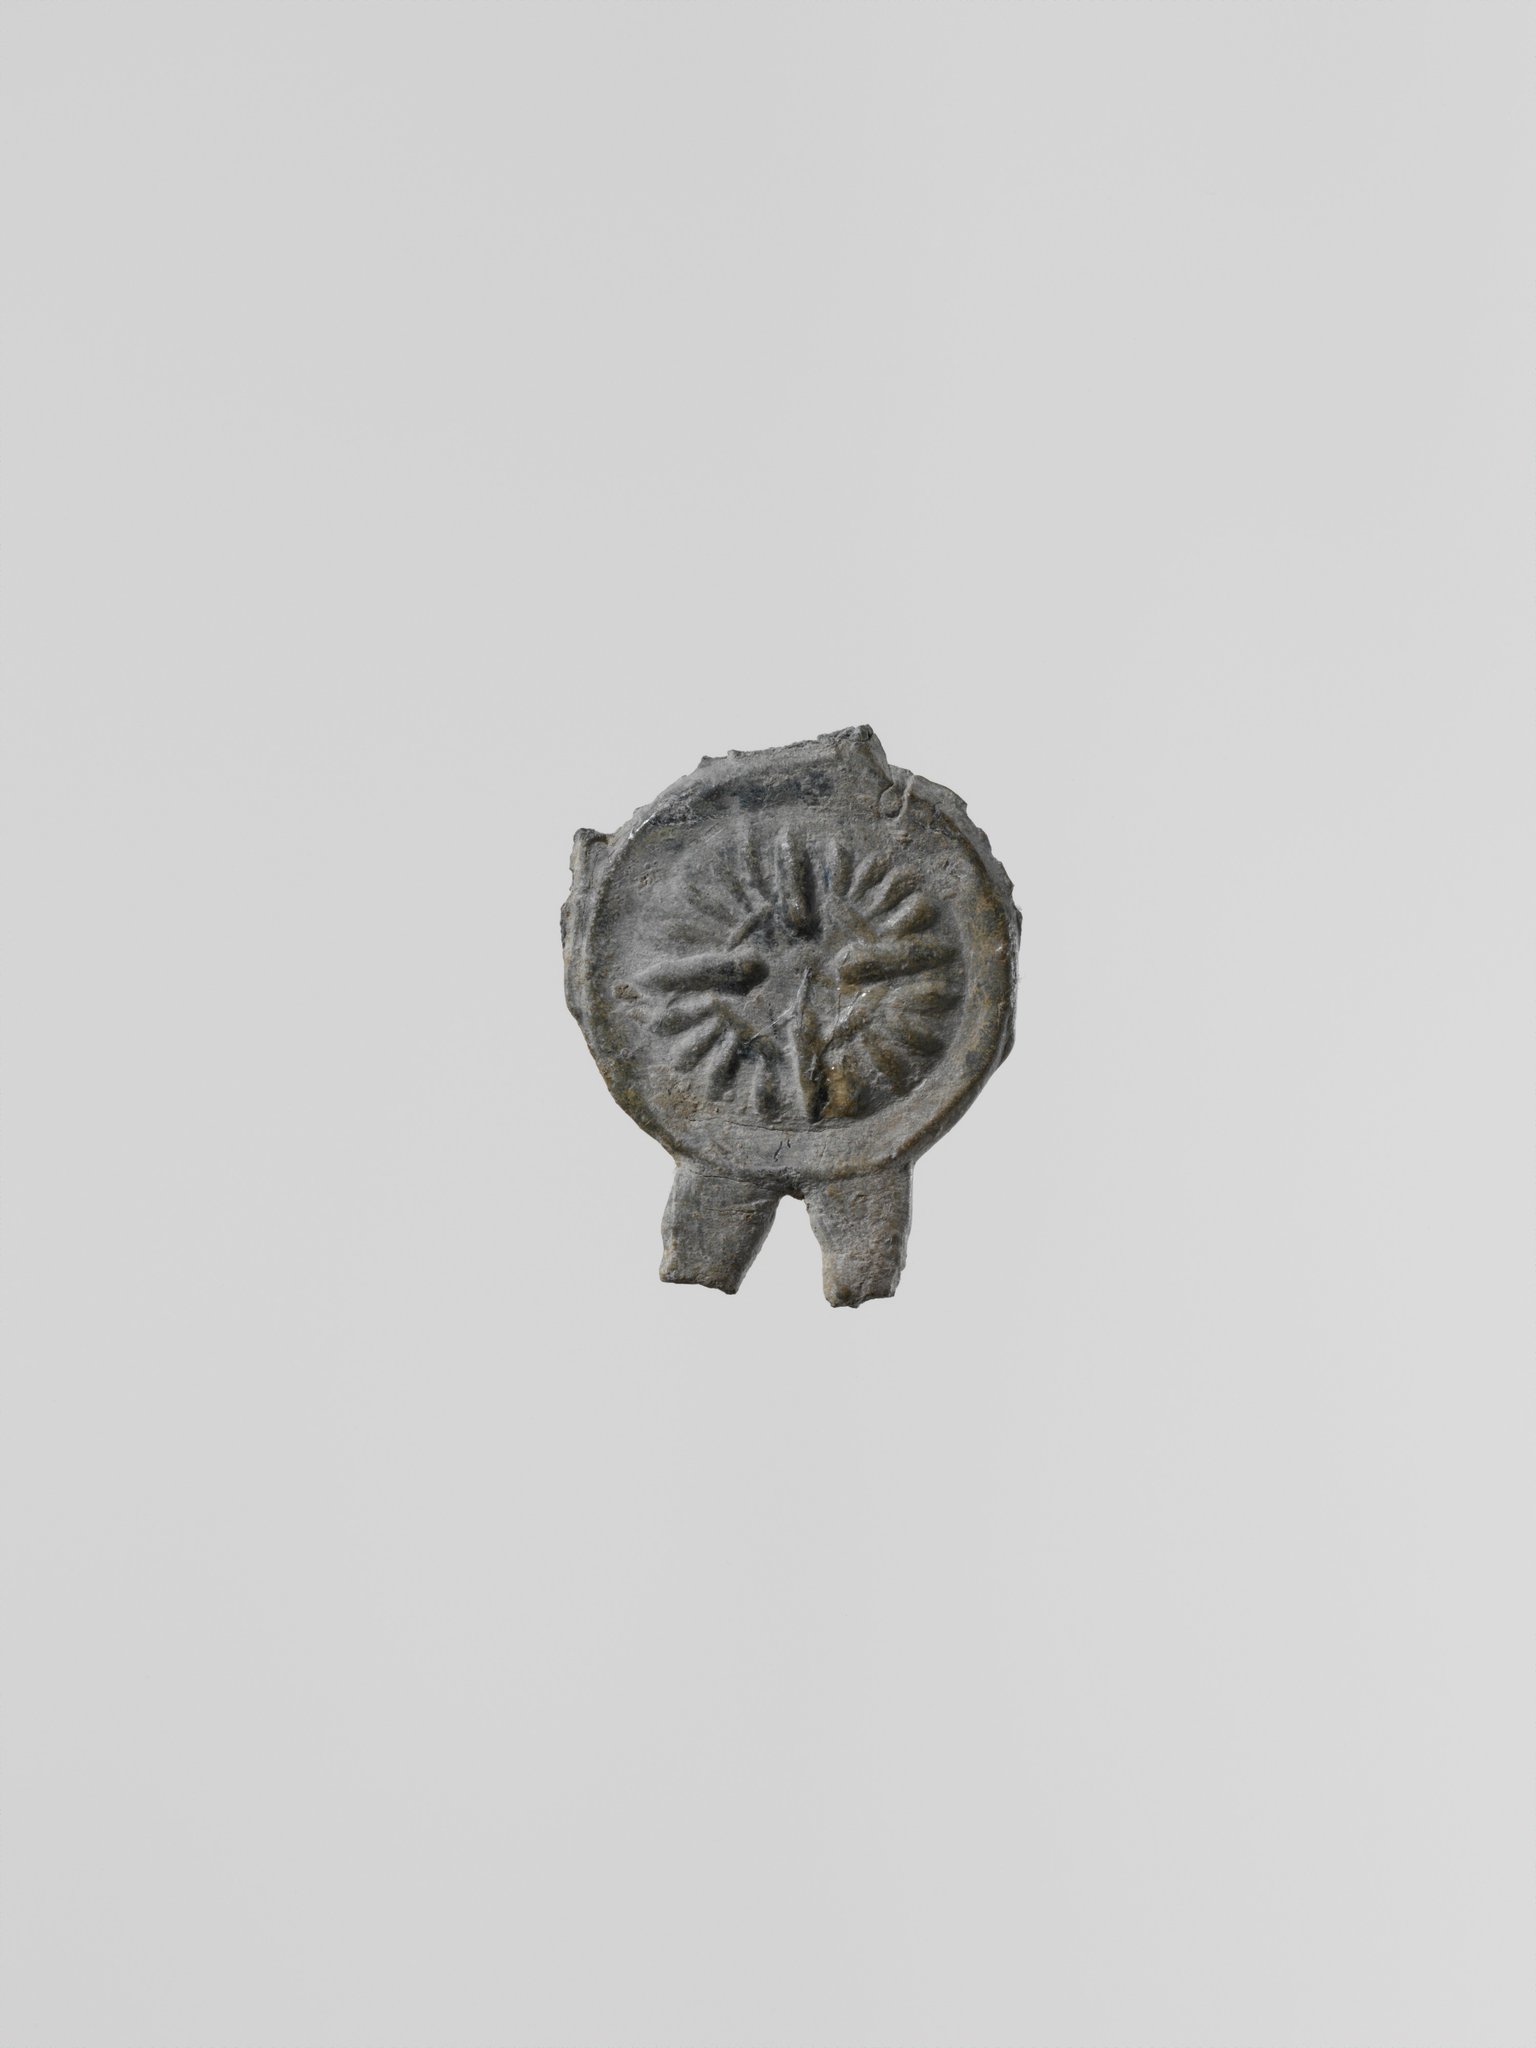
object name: statuette of a warrior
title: Statuette of a warrior-11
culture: greek, laconian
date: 7000-30 BCE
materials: lead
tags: shields